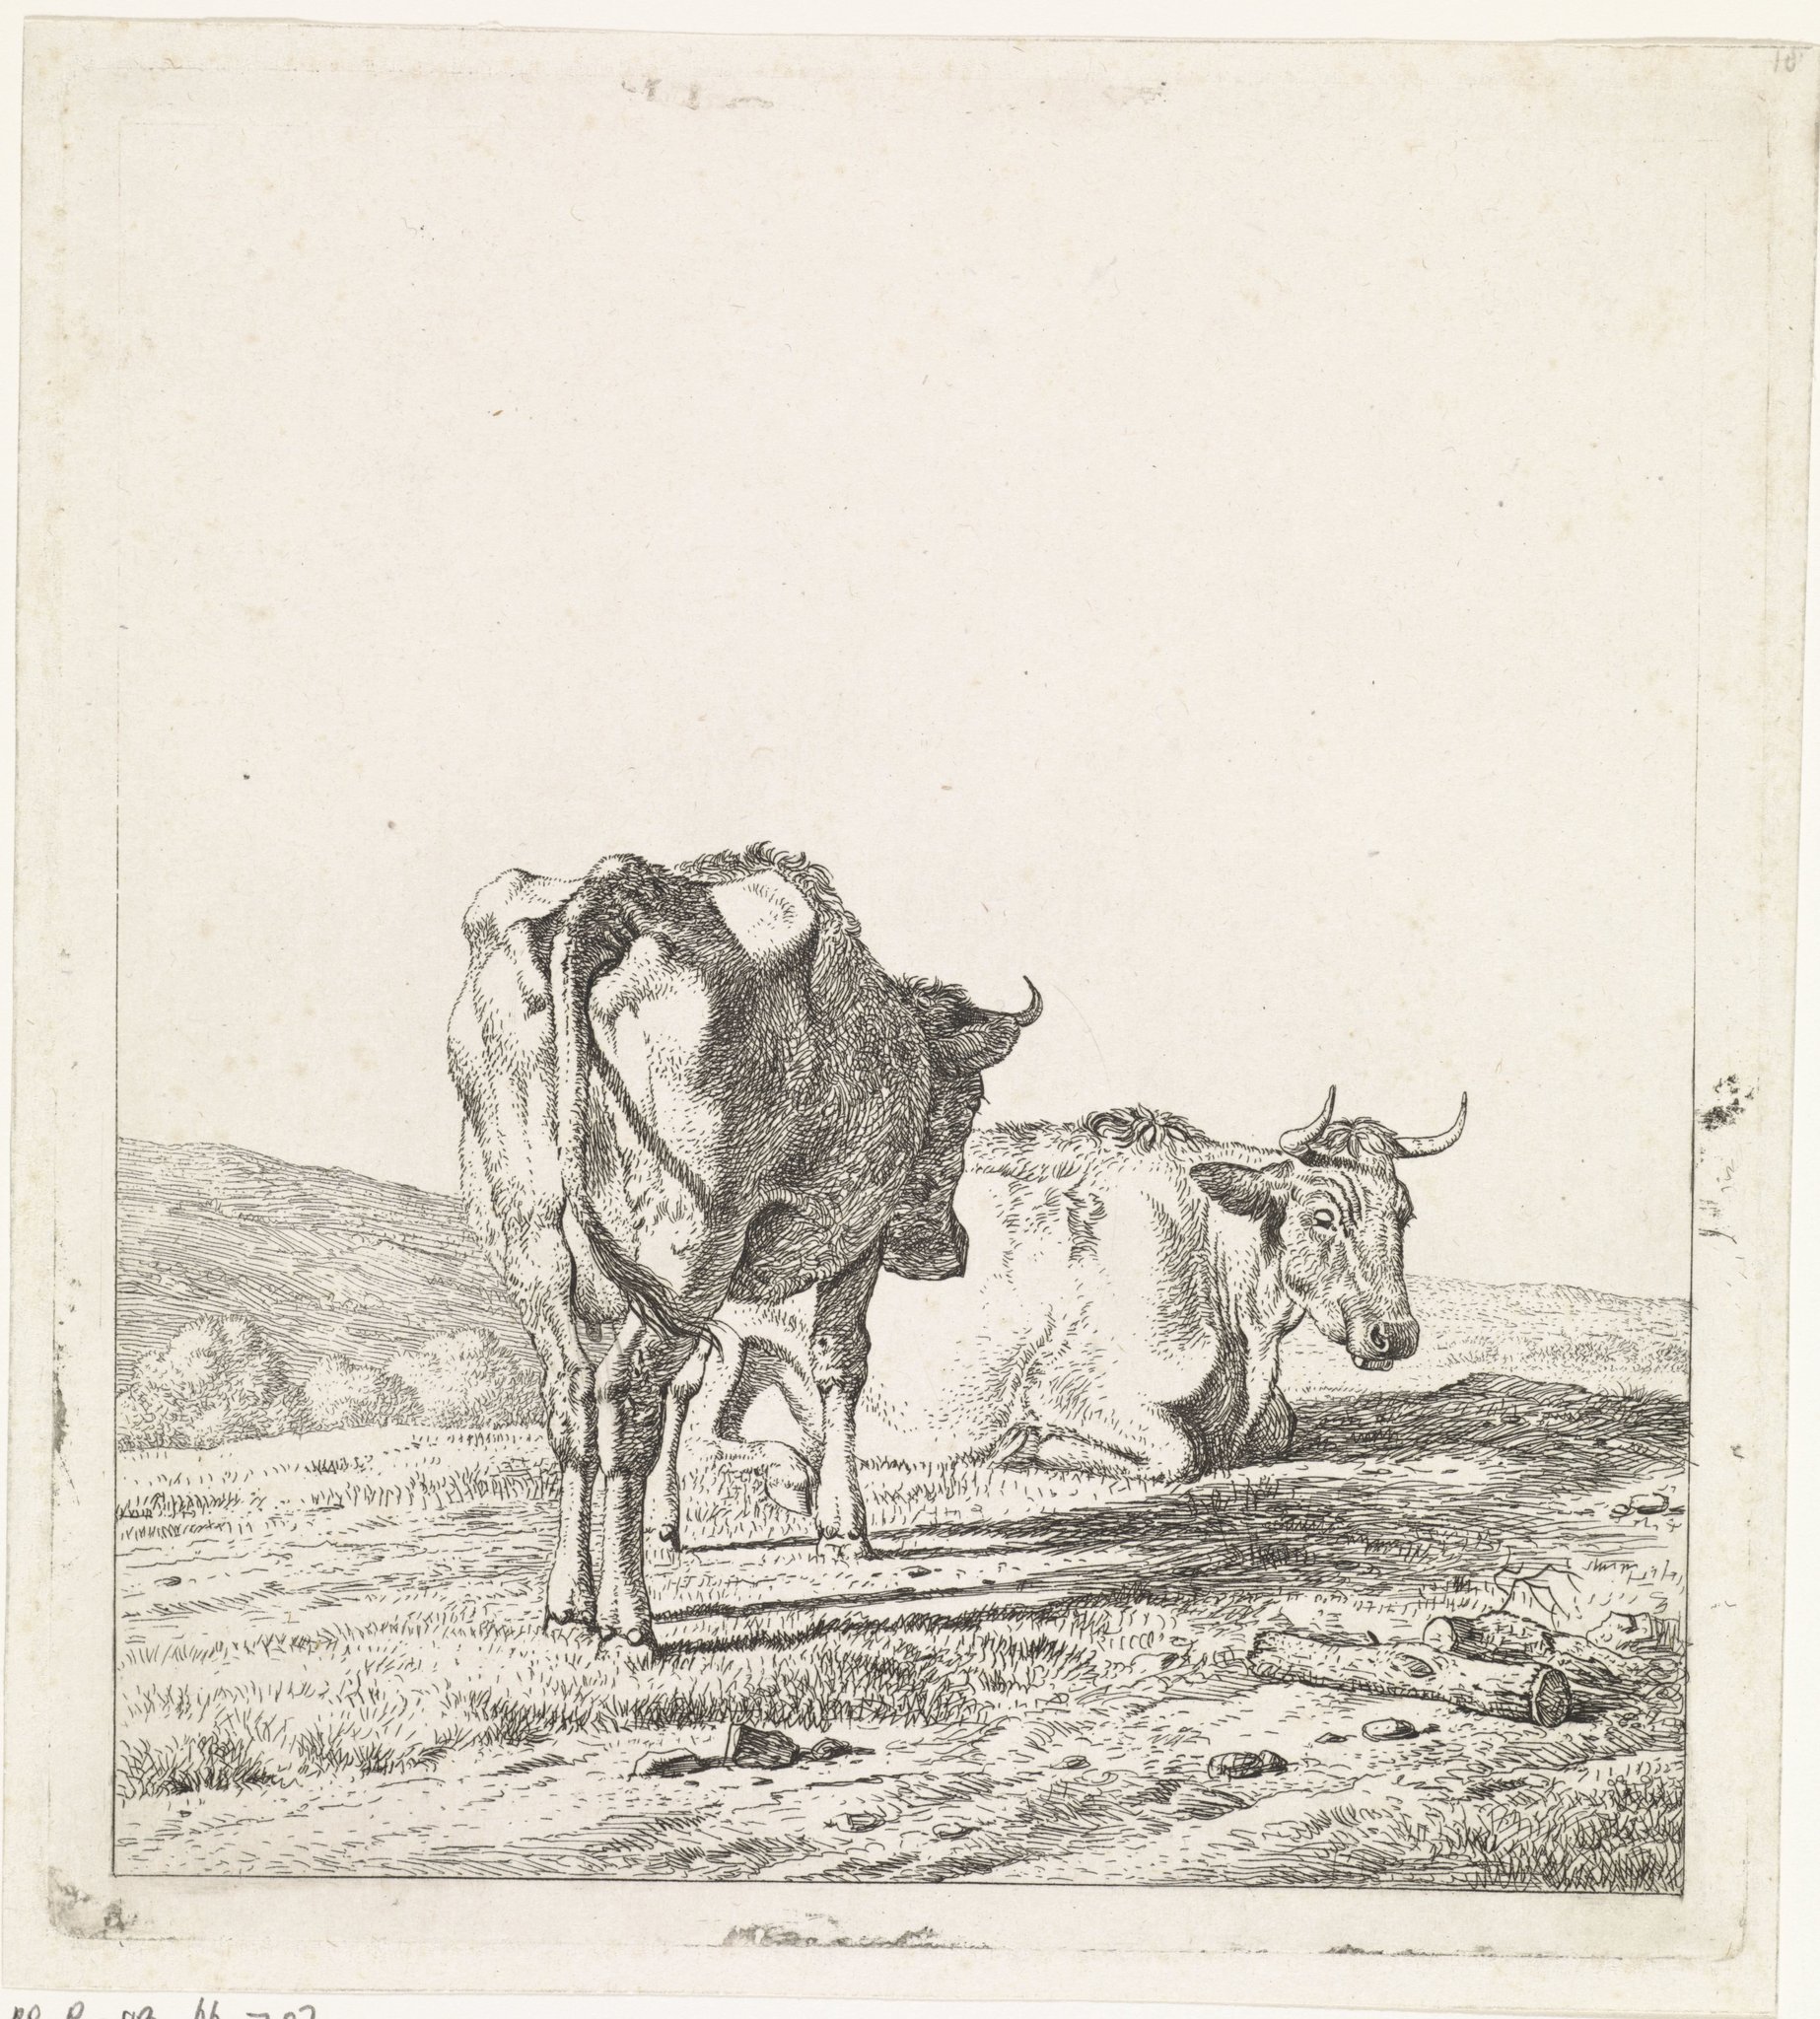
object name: print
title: Liggende en staande koe naar rechts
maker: wouter johannes van troostwijk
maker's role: draughtsman, painter, print maker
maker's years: 1782-1810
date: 1792-1810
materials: paper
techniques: etching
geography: amsterdam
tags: cow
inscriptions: collector's mark: Lugt 2165